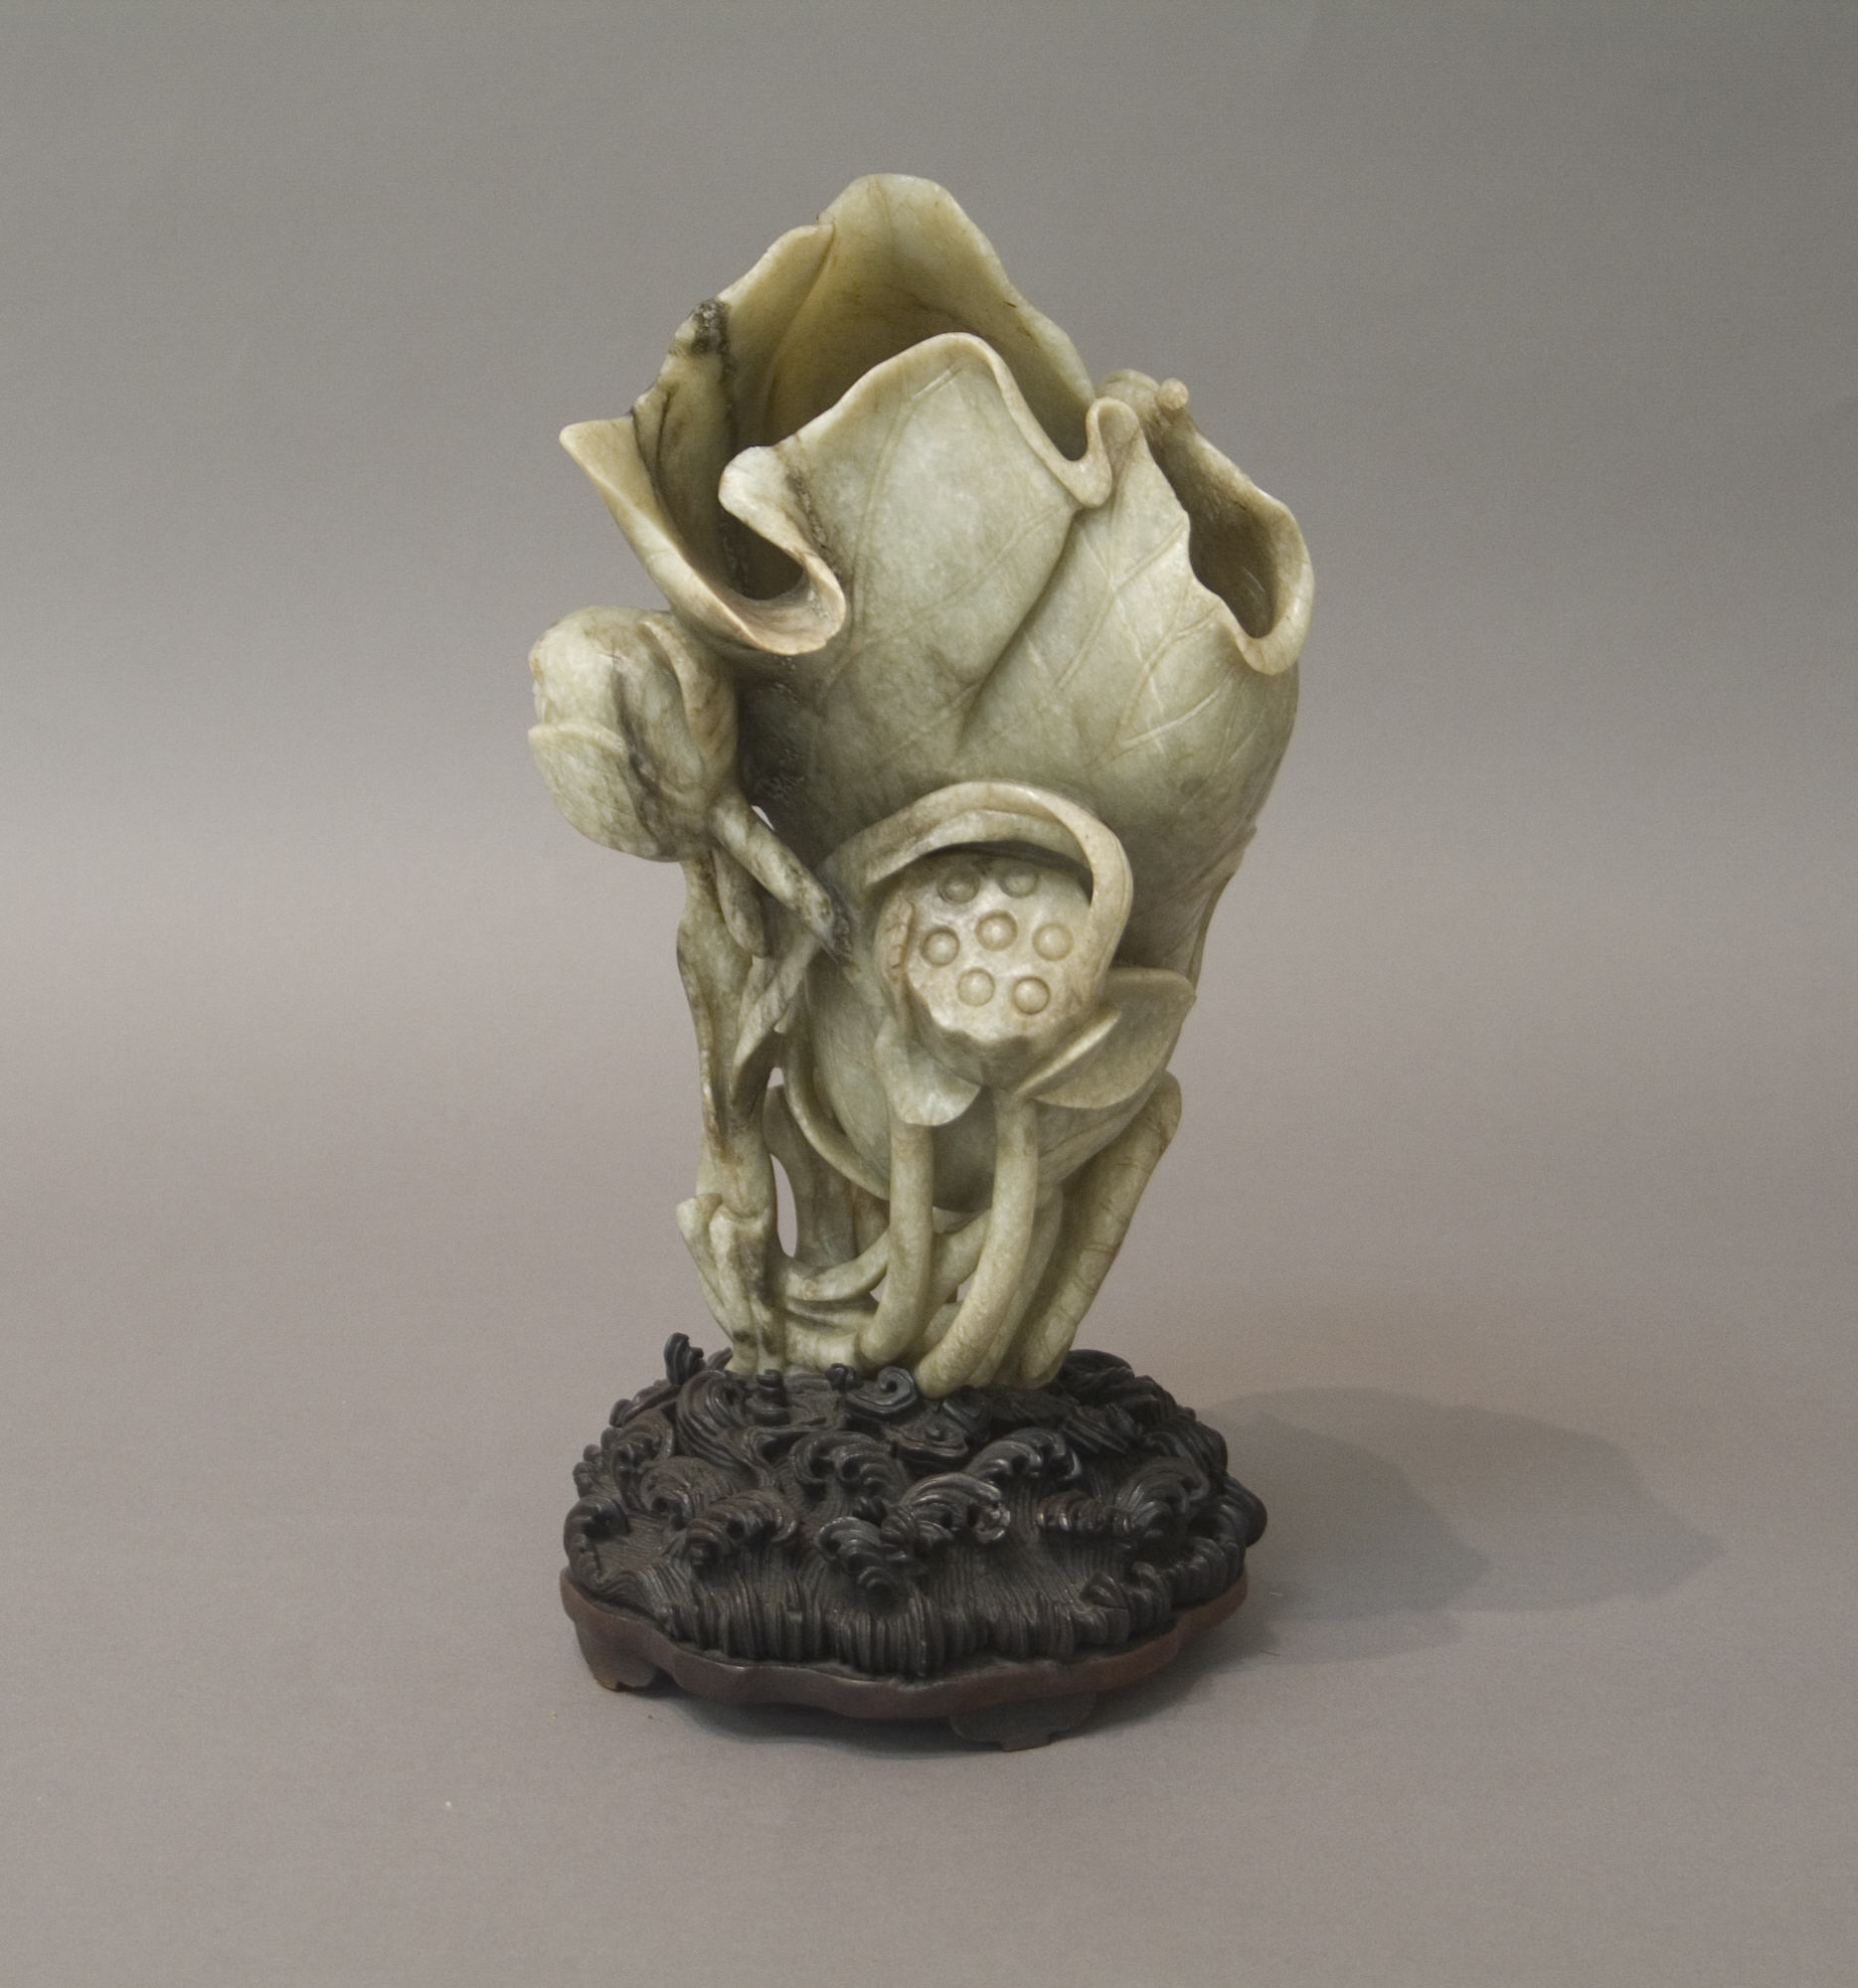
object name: vase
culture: chinese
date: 1201-1300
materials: jade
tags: flowers